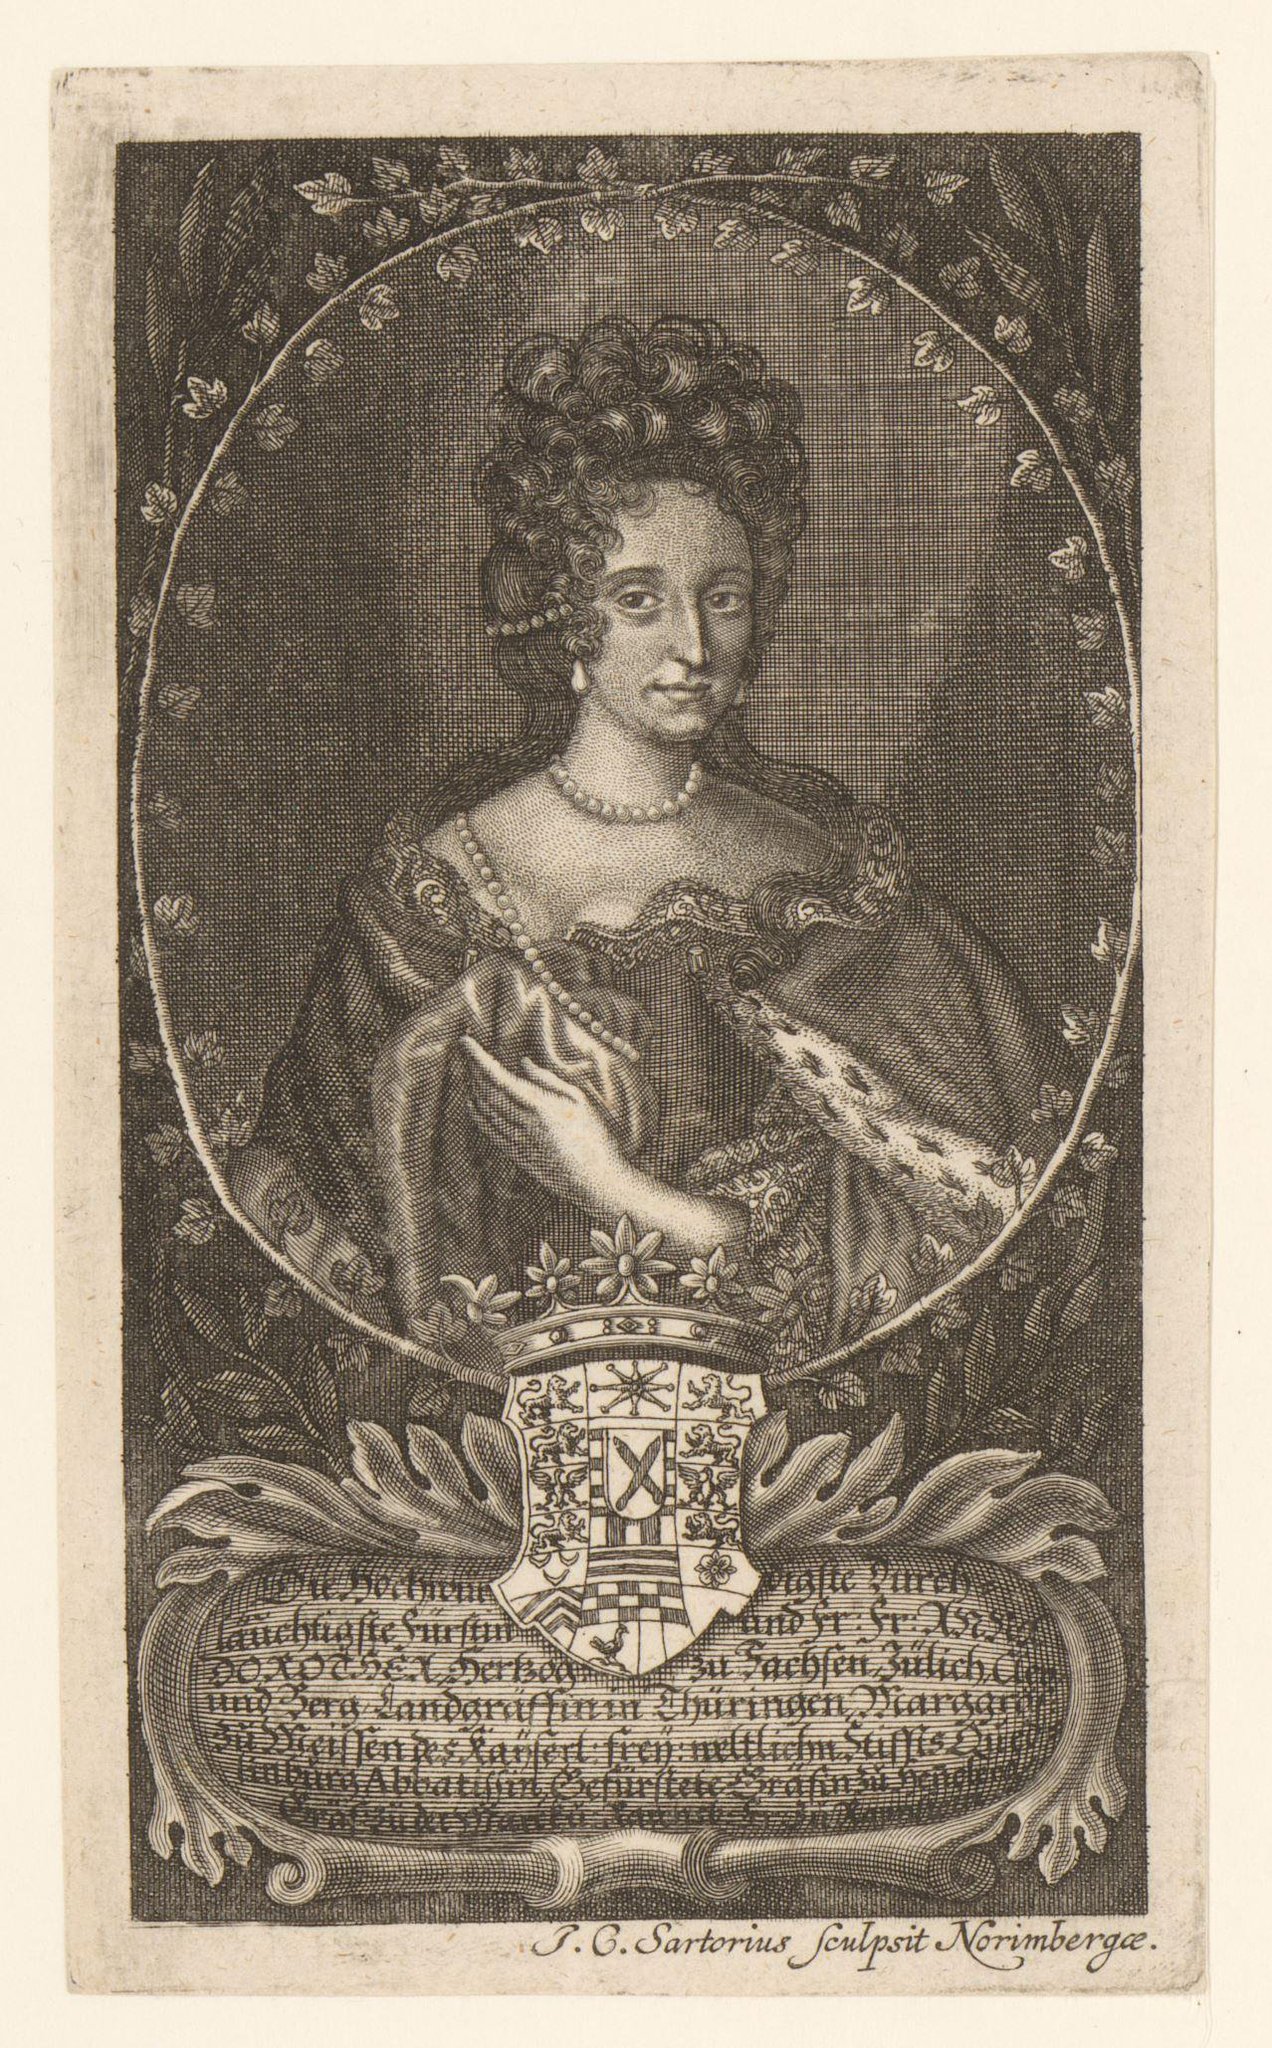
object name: print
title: Portret van Anna Dorothea van Sachsen-Weimar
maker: johann christoph sartorius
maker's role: print maker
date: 1680-1739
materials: paper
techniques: engraving, etching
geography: nuremberg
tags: historical persons - bb - woman, armorial bearing, heraldry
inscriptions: collector's mark: Lugt 2228